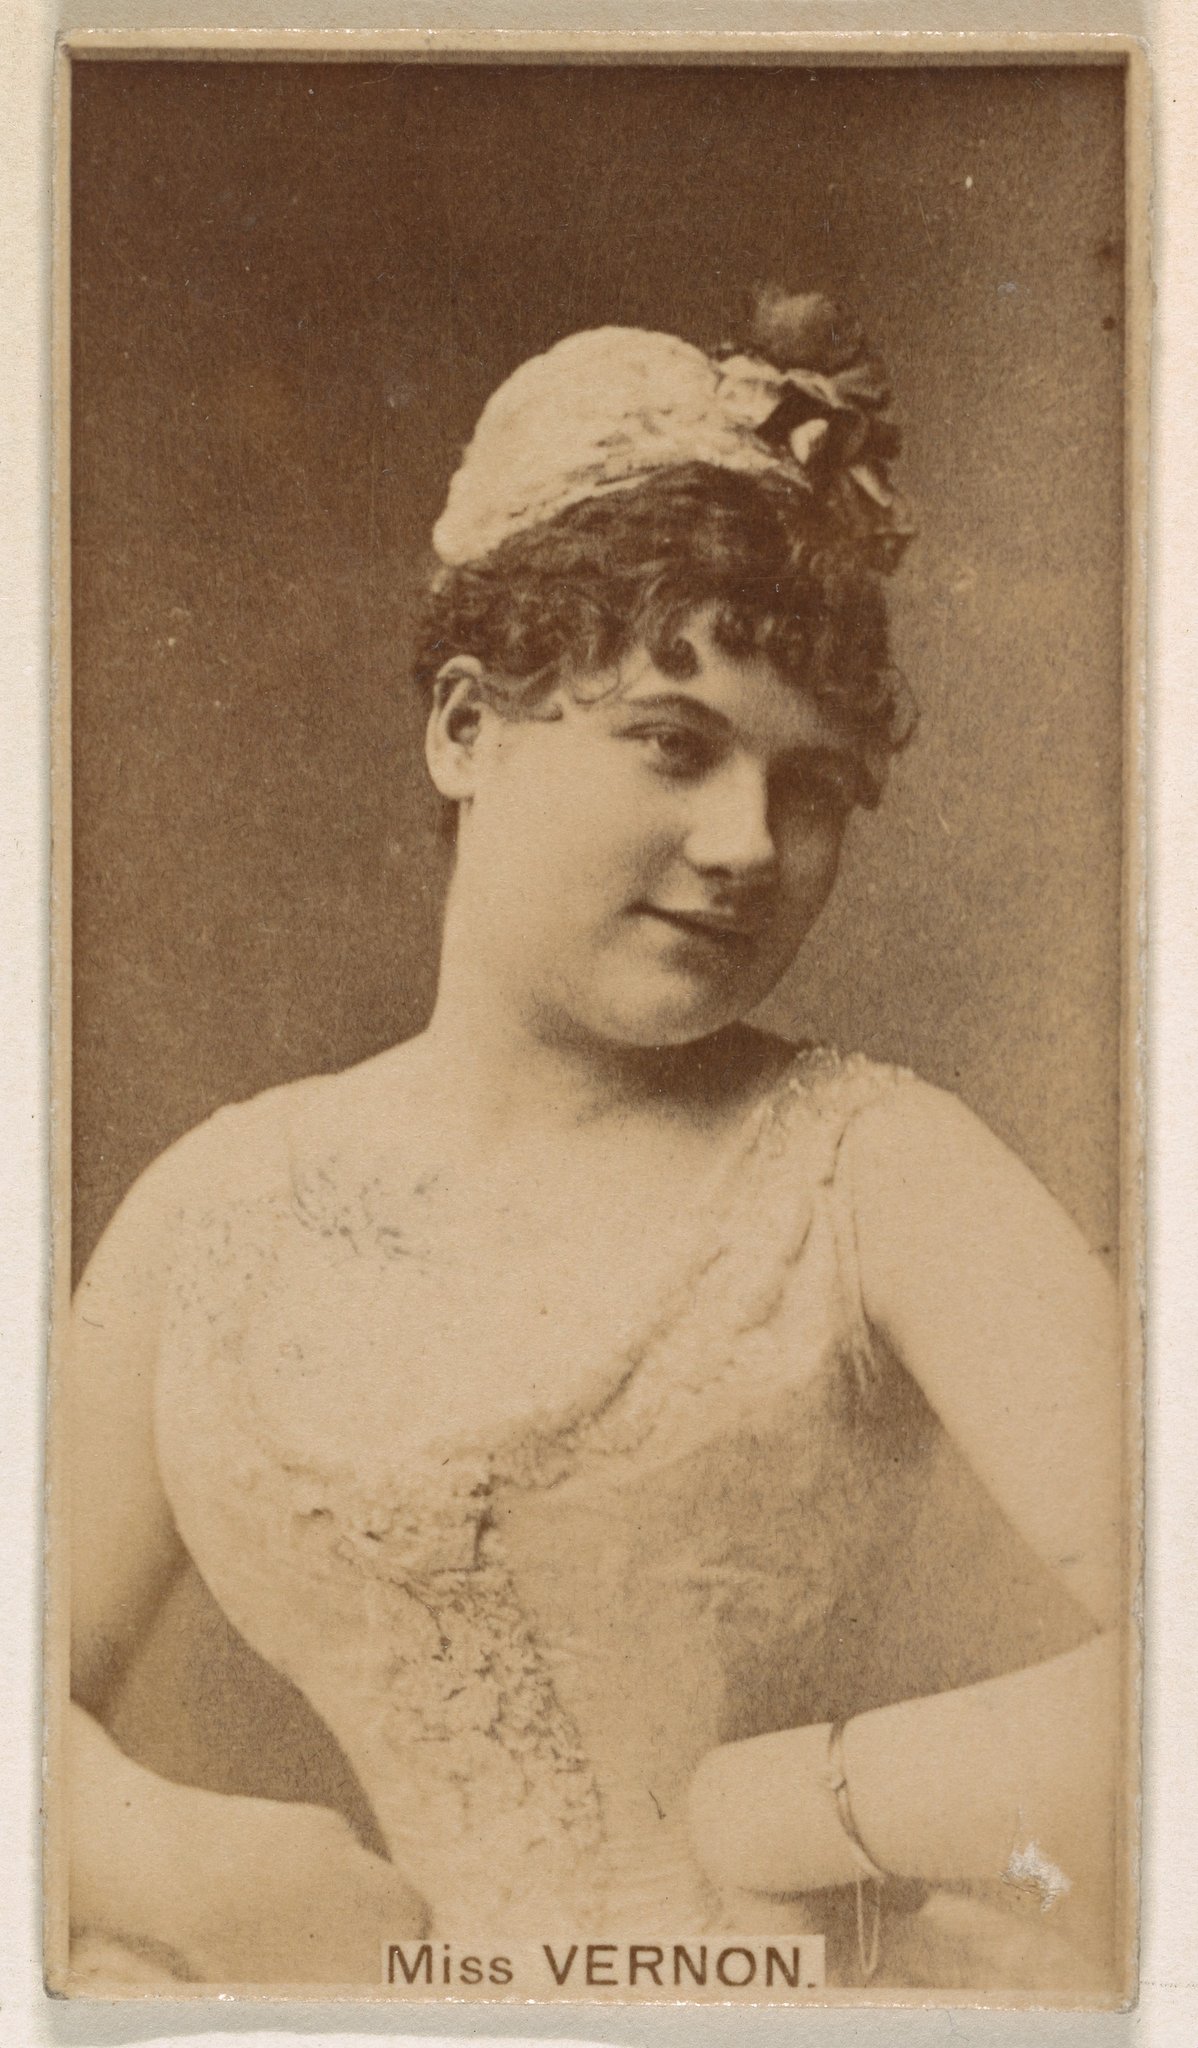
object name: photograph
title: Miss Vernon, from the Actresses series (N245) issued by Kinney Brothers to promote Sweet Caporal Cigarettes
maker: kinney brothers tobacco company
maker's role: publisher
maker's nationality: american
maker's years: 1869-2011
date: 1890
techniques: albumen silver print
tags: portraits,women,actresses